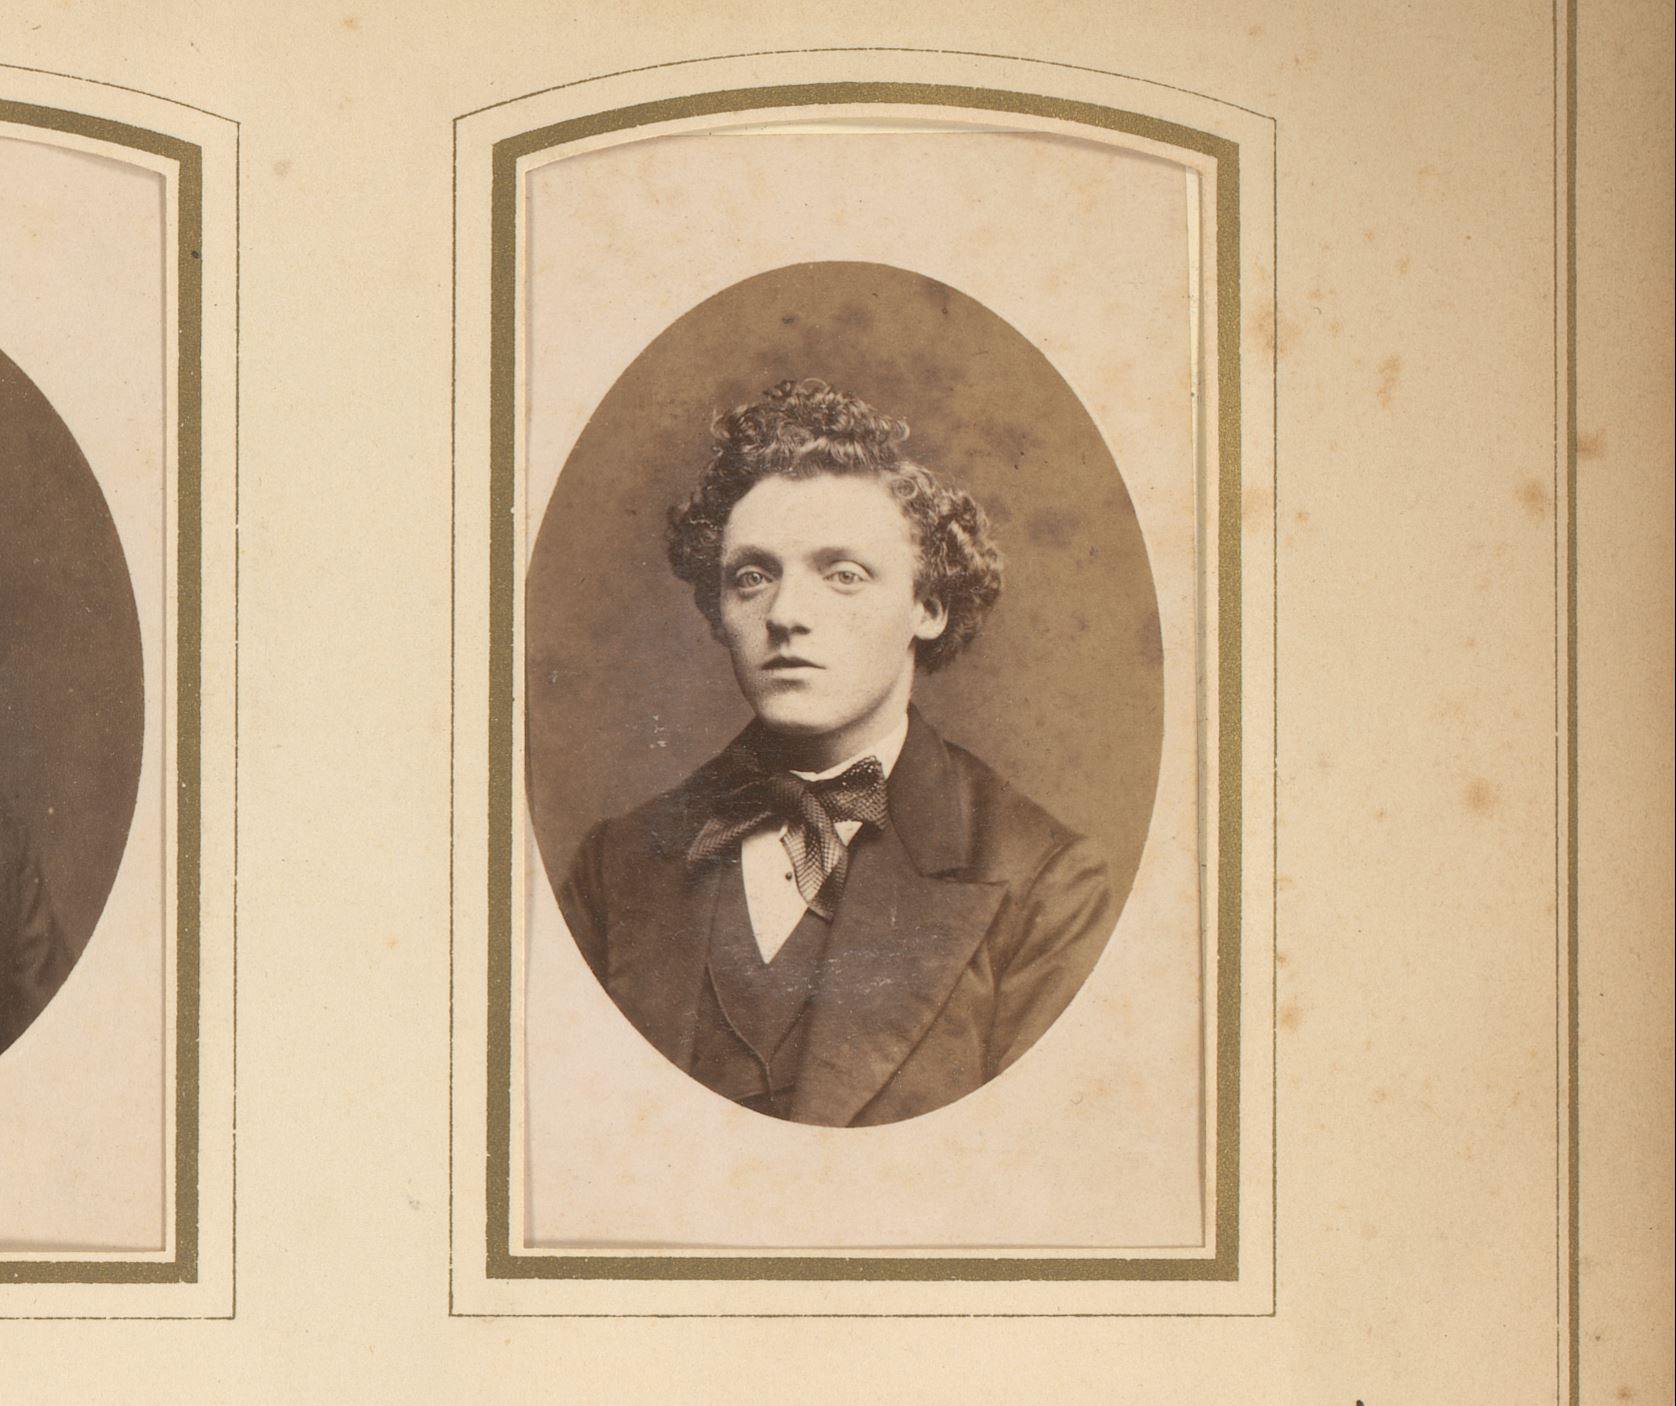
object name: album leaf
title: Portret van een jonge man met vlinderstrik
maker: hendrik anthonie karel ringler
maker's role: draughtsman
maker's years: 1846-1879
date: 1872-1879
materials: cardboard, photographic support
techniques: albumen print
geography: leeuwarden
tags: historical persons, youth, adolescent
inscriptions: inscription: ‘H.A.K. RINGLER/ SCHOOLSTRAAT/ LEEUWARDEN/ De plaat blijft tot nabestelling bewaard/ Van ieder portret kunnen vergrootingen/ geleverd worden.’